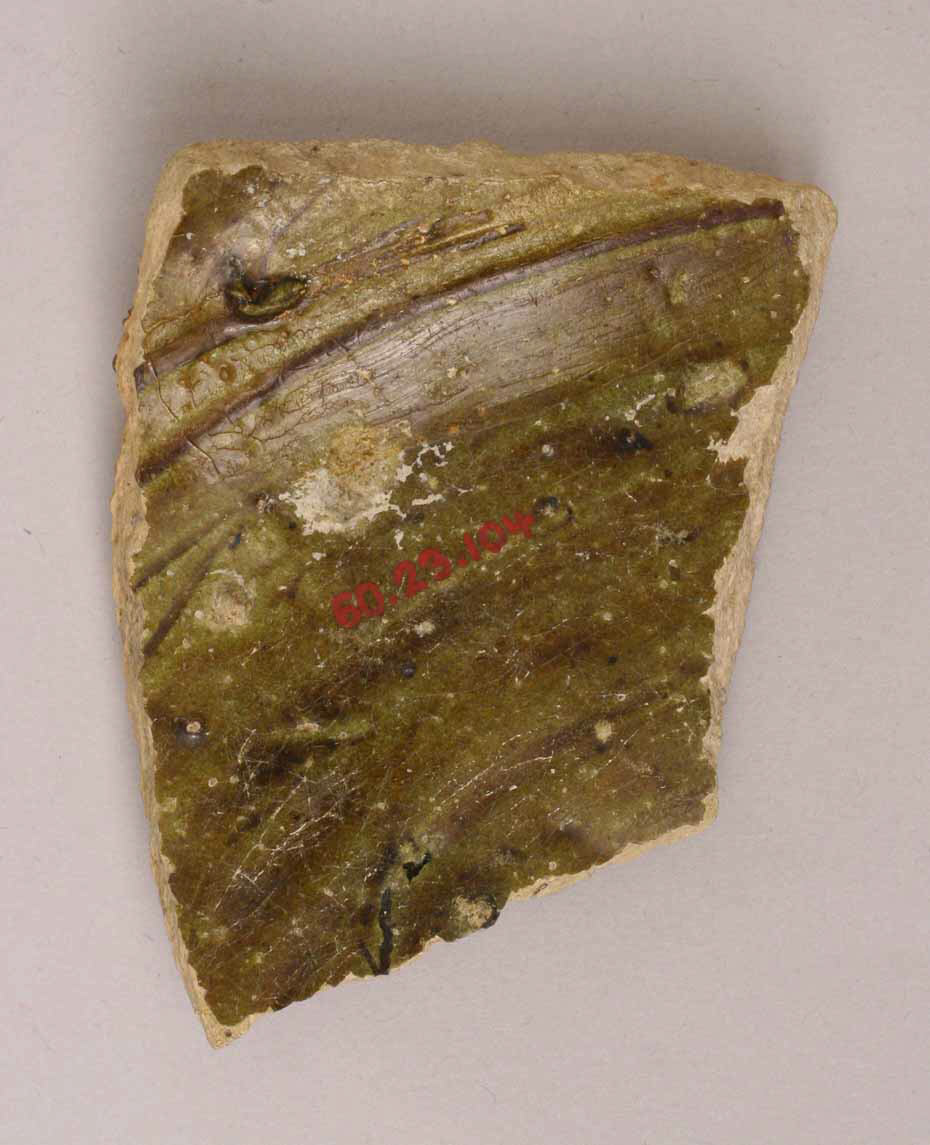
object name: fragment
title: Ceramic Fragment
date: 1001-1100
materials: earthenware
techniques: glazing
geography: saudi arabia